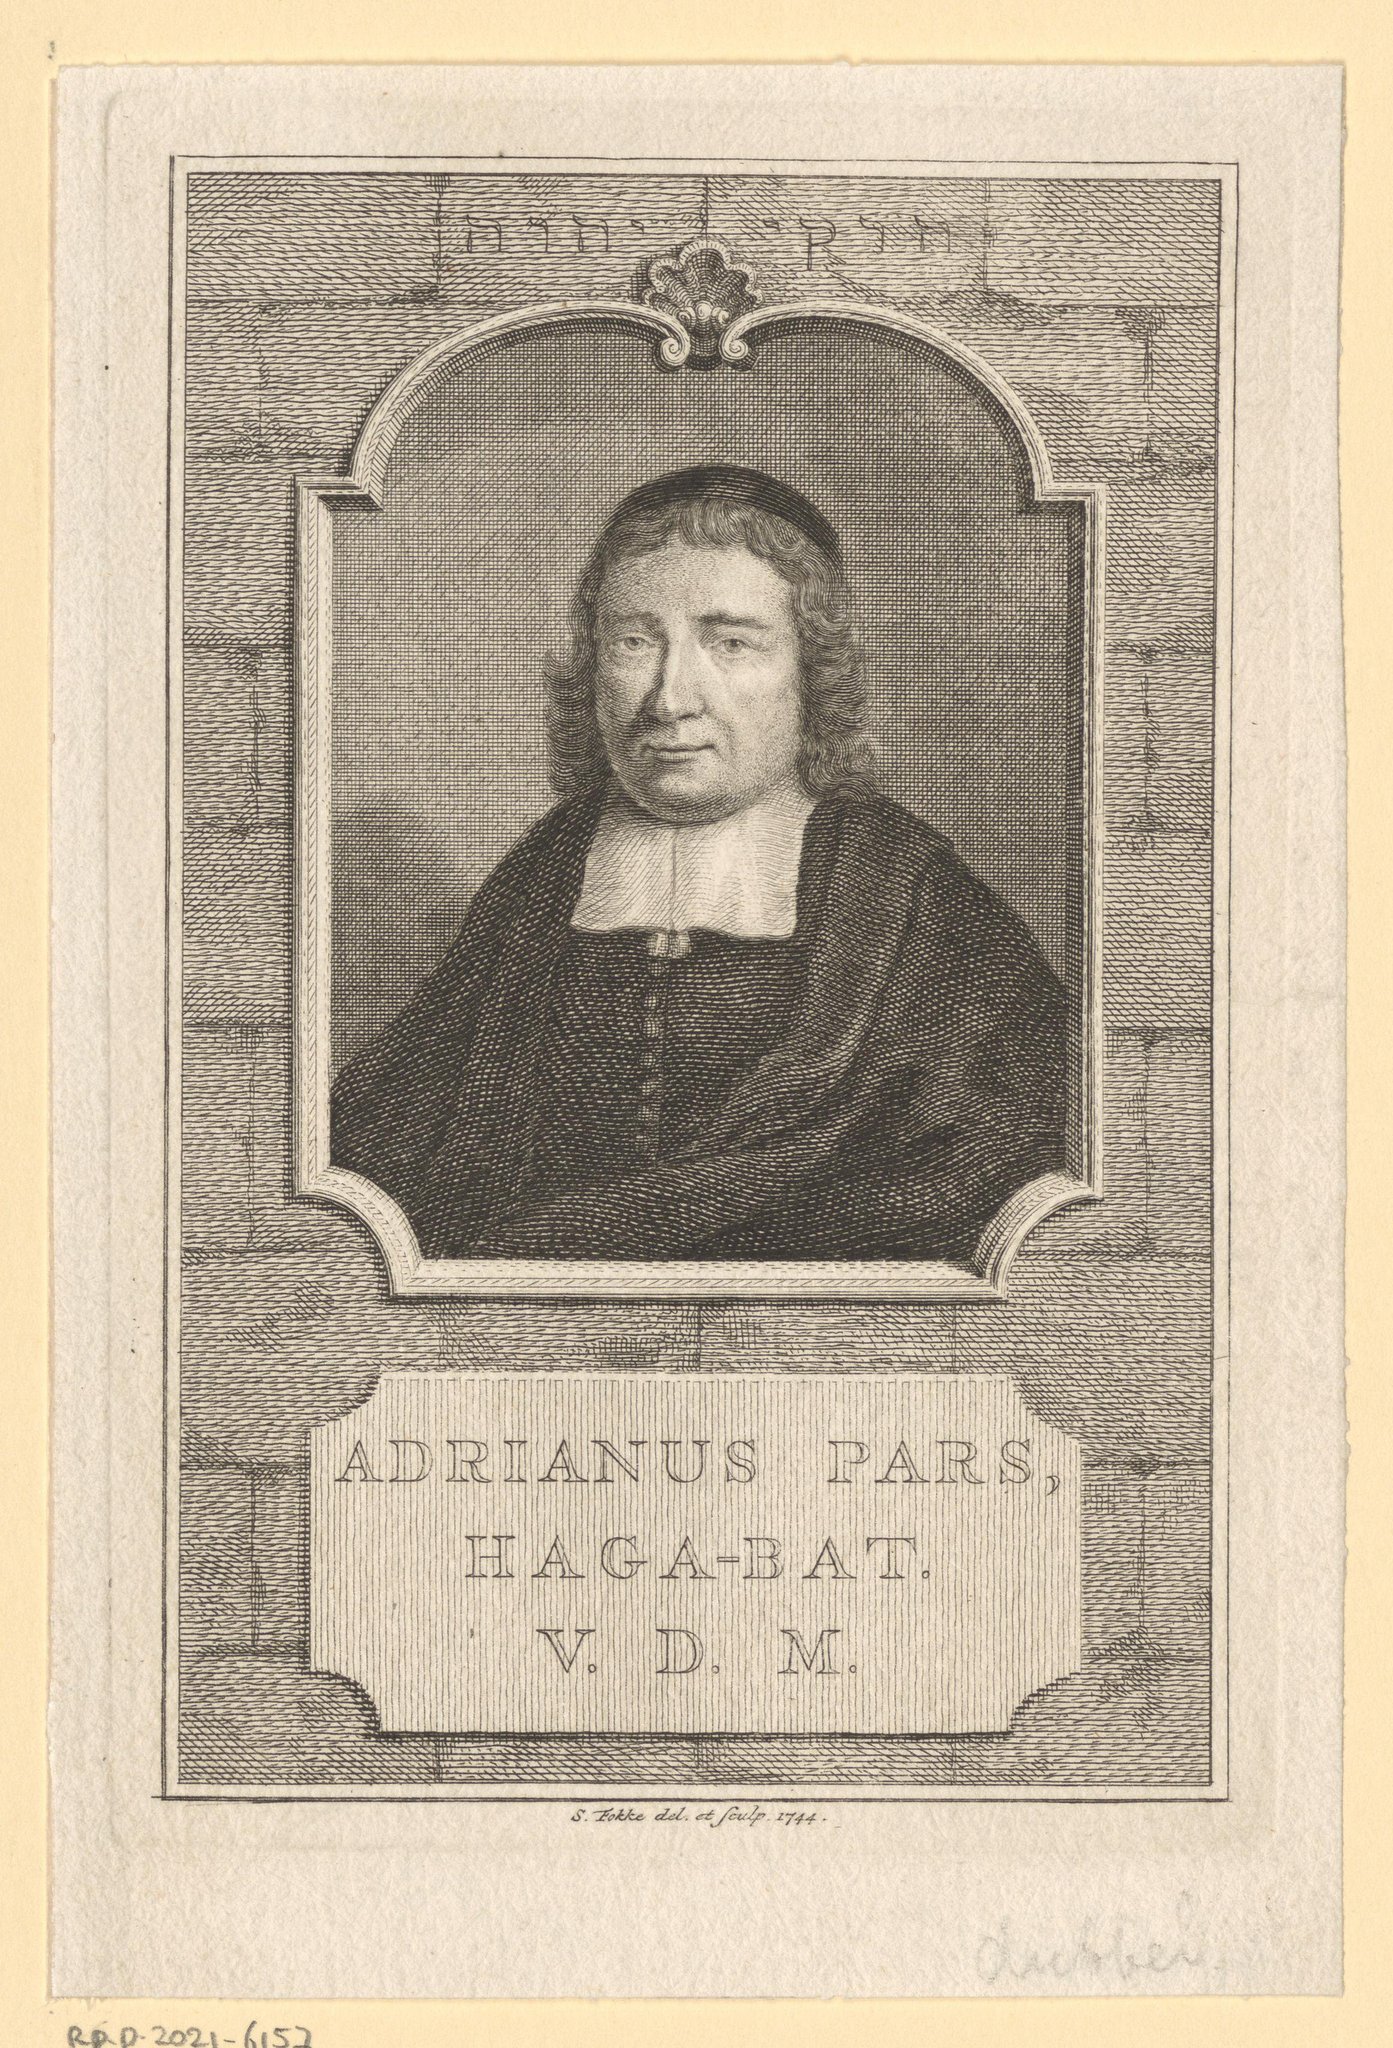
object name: print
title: Portret van Adriaan Pars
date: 1744-1745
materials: paper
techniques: engraving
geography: leiden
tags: the hague, adult man, historical persons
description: Prent uit: Pars, Adriaan. Catti aborigines Batavorum: Dat is: De Katten de voorouders der Batavieren, ofte de twee Katwijken, aan See an aan den Rijn. Amsterdam: Gerard de Groot, Leiden: Johannes Arnoldus Langerak, 1745, dl. 1.